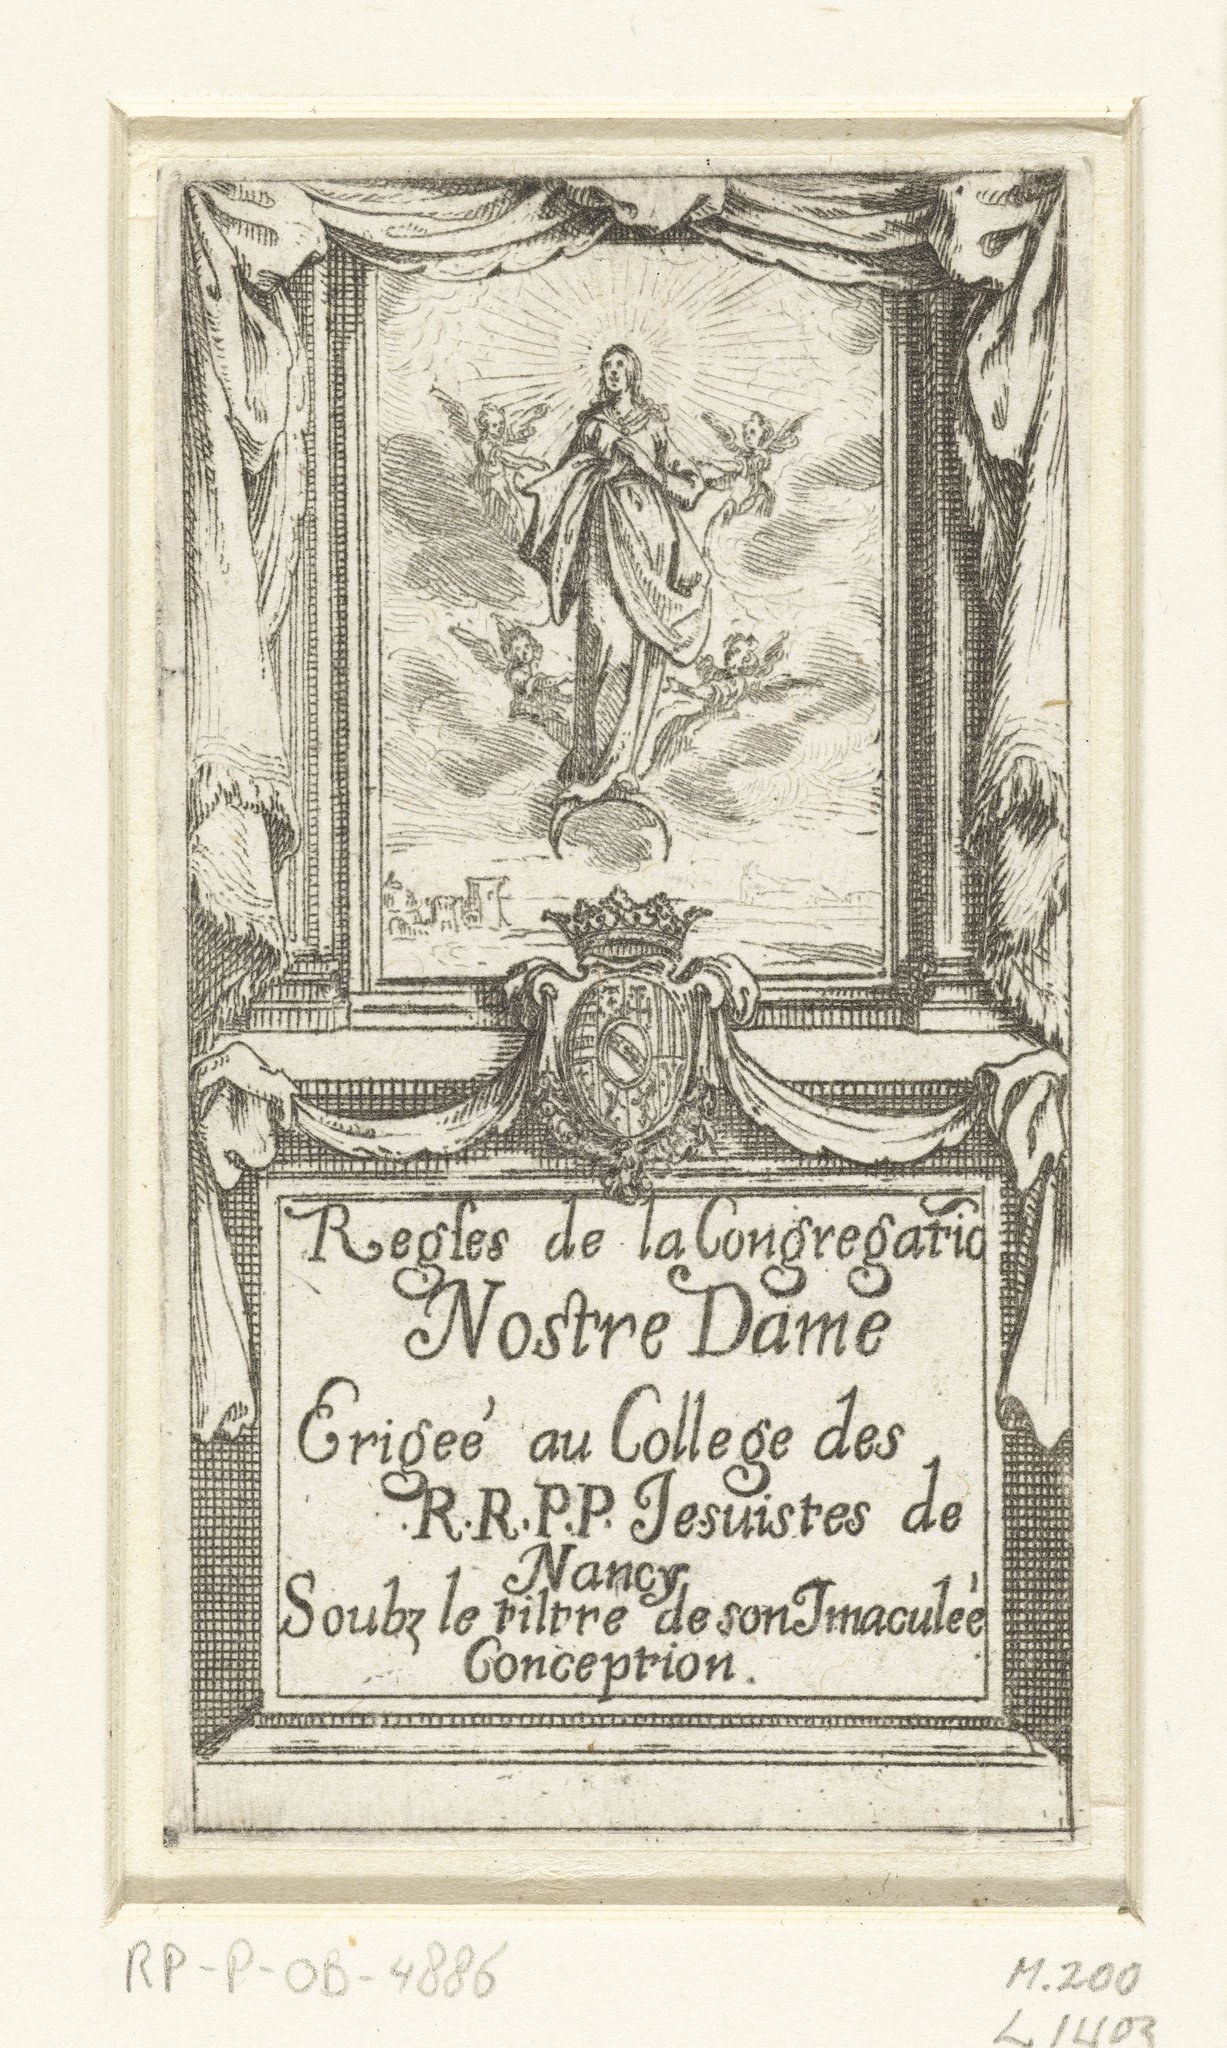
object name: print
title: Titelblad voor 'Regles de la Congregatio Nostre Dame'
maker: jacques callot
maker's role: draughtsman, print maker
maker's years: 1592-1635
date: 1634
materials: paper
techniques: etching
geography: nancy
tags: madonna on the crescent of the moon (sometimes called queen of heaven) (in mandorla), title-page, 'immaculata', 'purisima': mary, usually standing on a crescent moon, descending from heaven, exempt from original sin (sometimes trampling serpent), armorial bearing, heraldry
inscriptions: collector's mark: Lugt 240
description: Cartouche met Franse tekst, waarboven een wapenschild en een voorstelling van Maria op een halve maan omgeven door engelen.